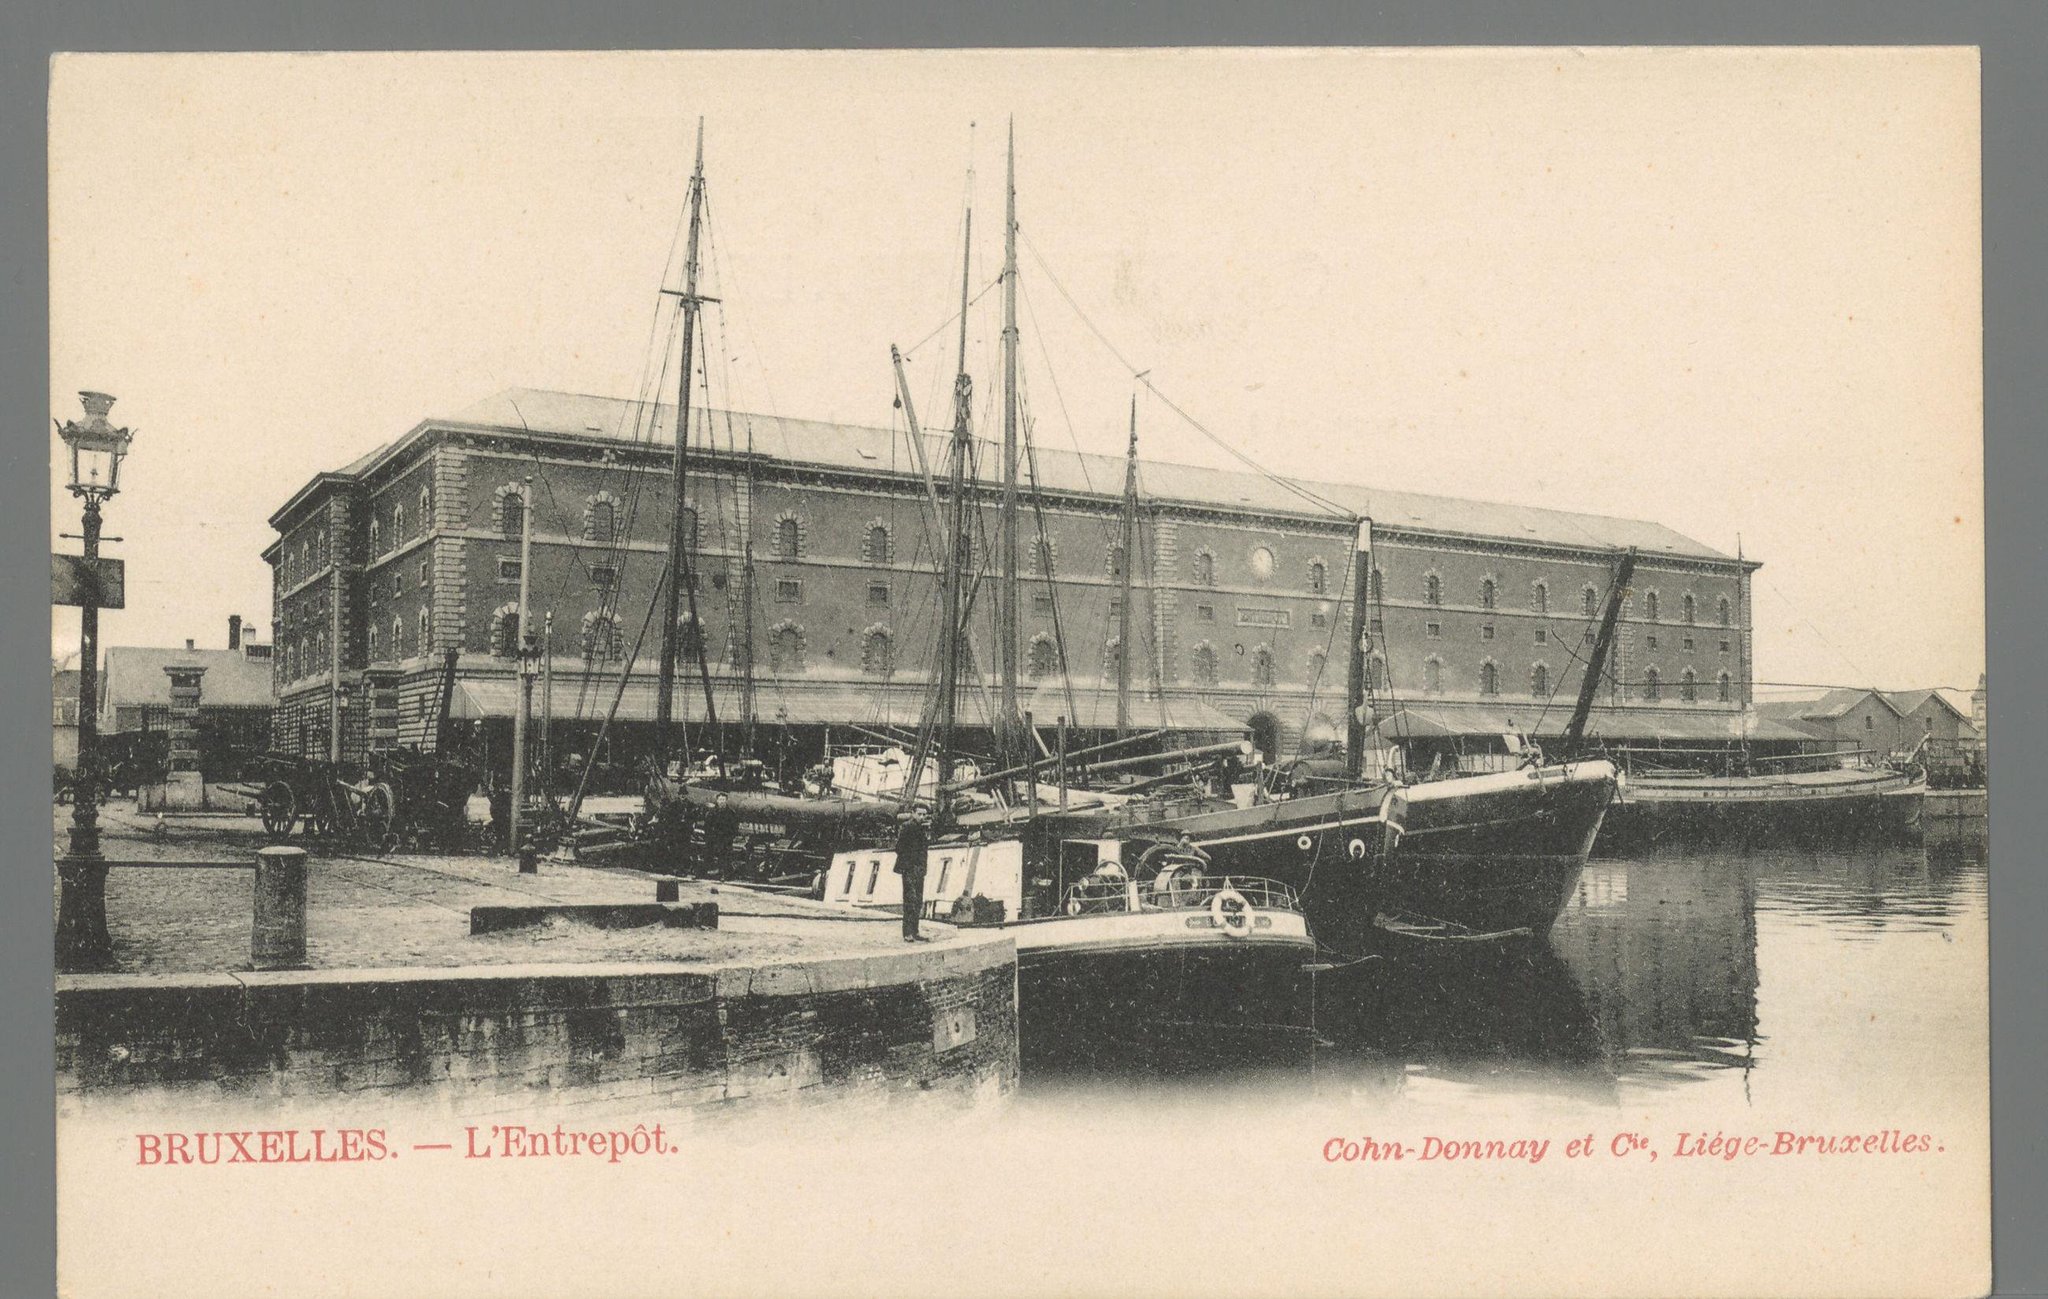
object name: ansichtkaart, prentbriefkaart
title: Bruxelles. L'Entrepôt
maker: Anonymous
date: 1903-1906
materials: cardboard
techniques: photograph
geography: brussels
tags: warehouse (~ harbour), ships (in general), brussels